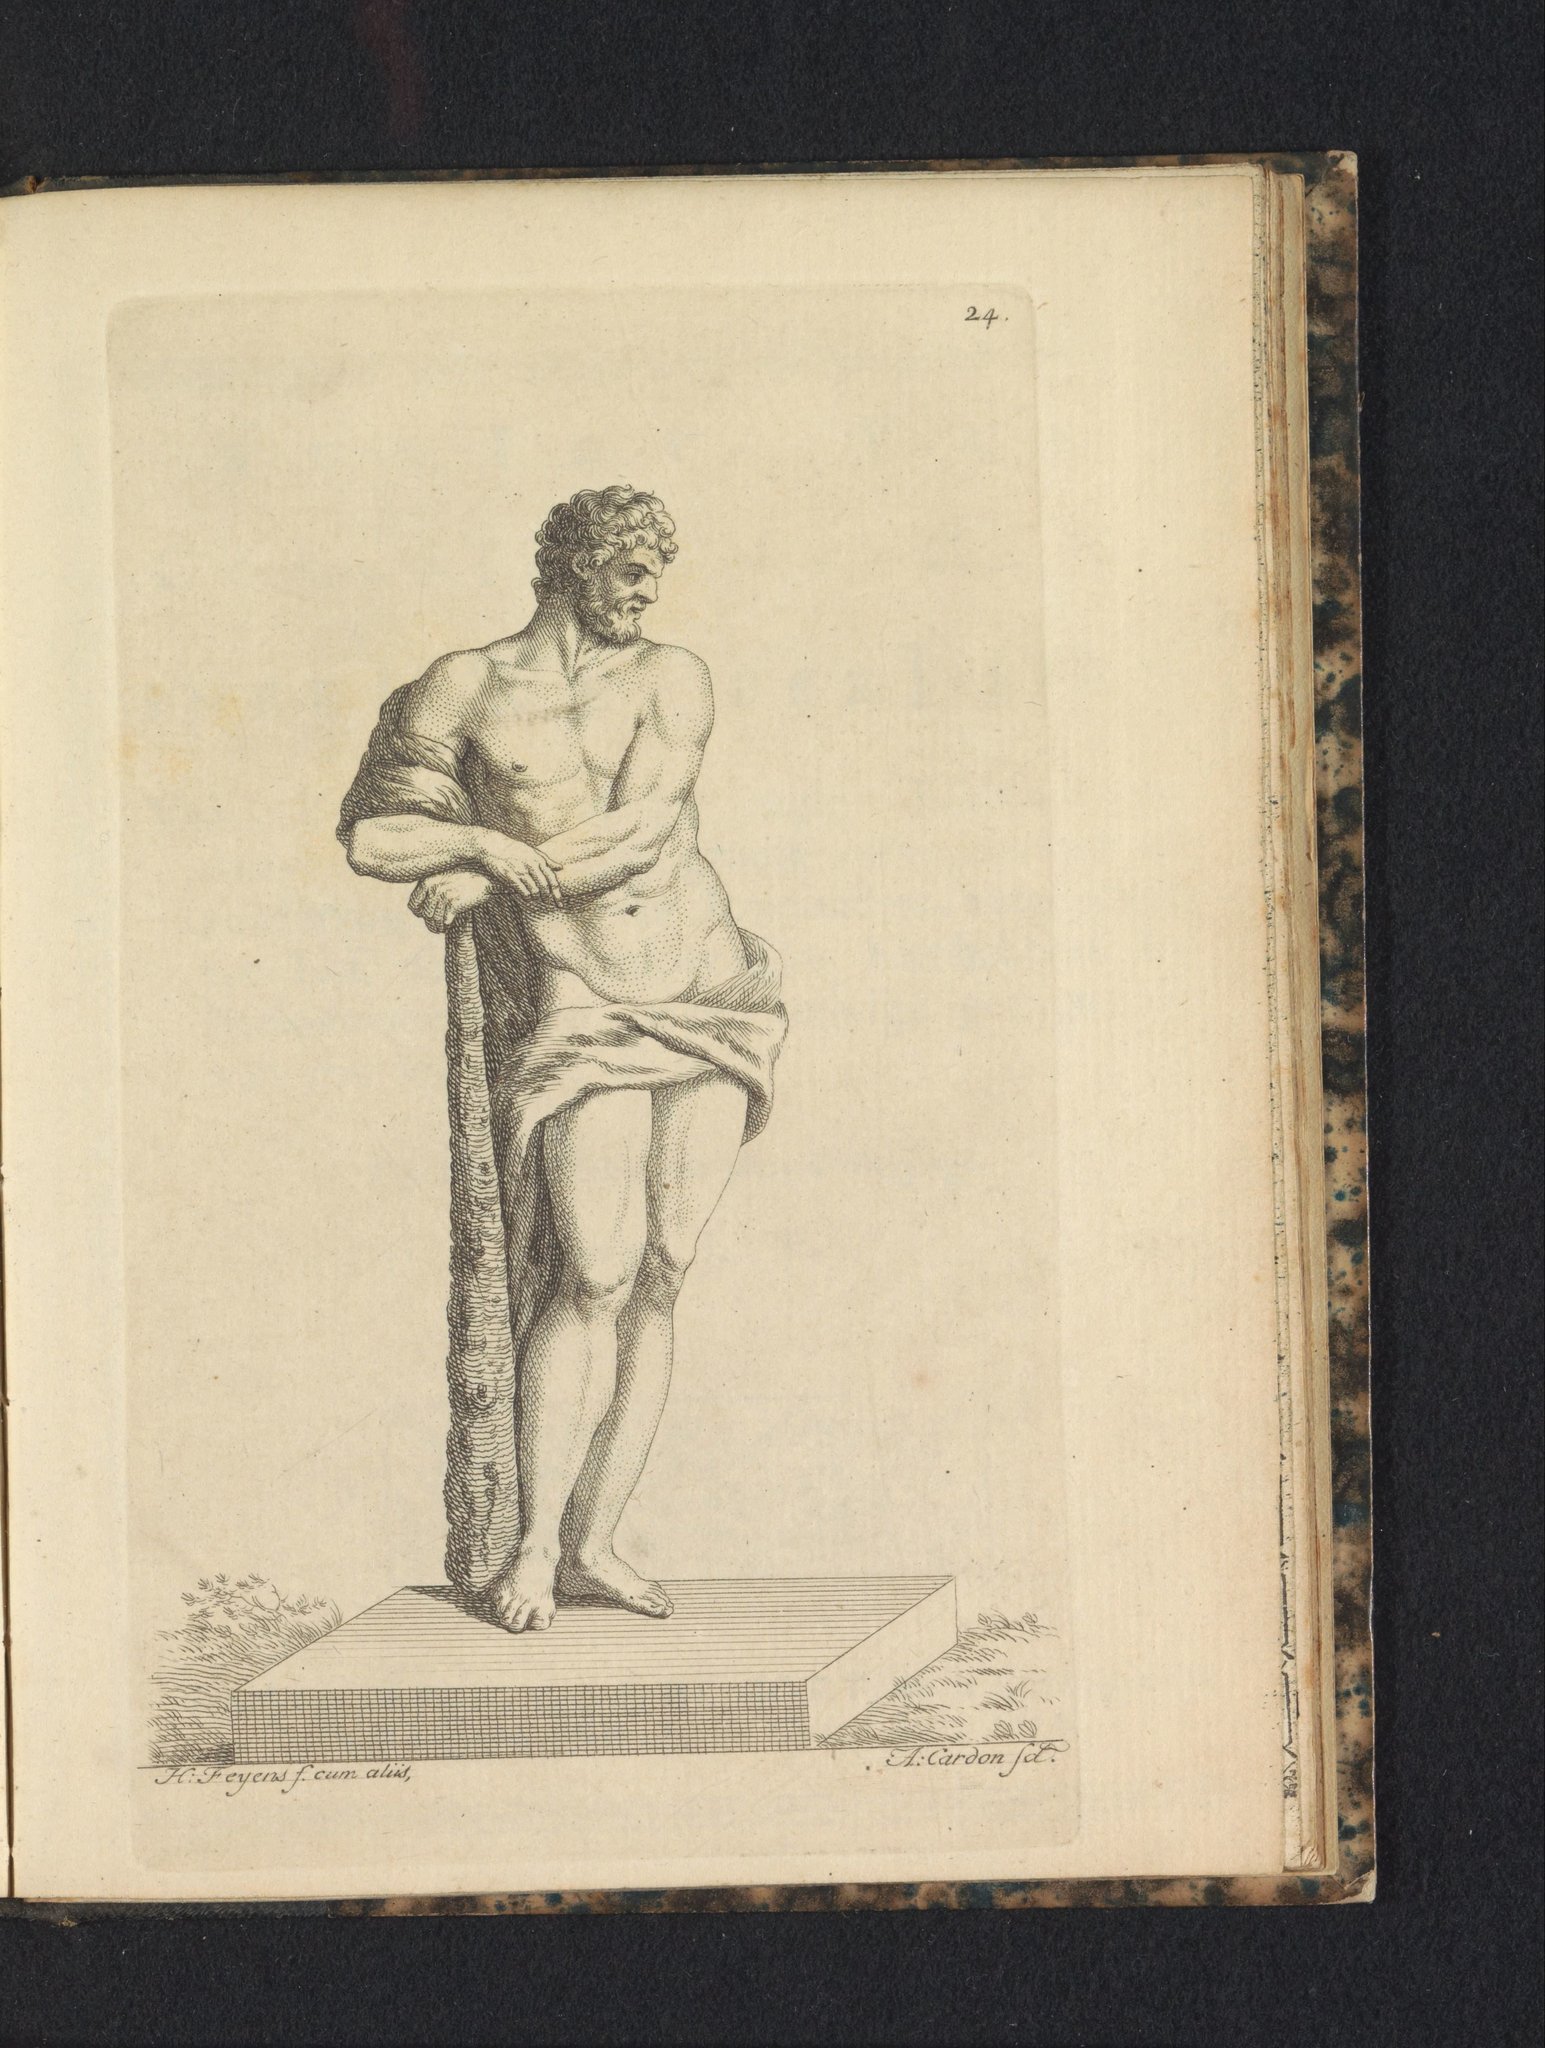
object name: print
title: Hercules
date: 1772-1773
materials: paper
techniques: engraving, etching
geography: southern netherlands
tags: (story of) hercules (heracles), piece of sculpture, reproduction of a piece of sculpture (+ clay, sand, etc. ~ arts), antwerp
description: Sculptuur van een staande Hercules, met de knots rustend op de grond. Beeld gemaakt door Henry Feyens, Jaques P.H. Trachez, Ignace van den Berghe & Pierre Grae, bij de Keizerspoort. Genummerd rechtsboven in de plaat: 24. Onderdeel van de verzameling van figuren en beelden gemaakt van sneeuw in de straten van Antwerpen in januari 1772.